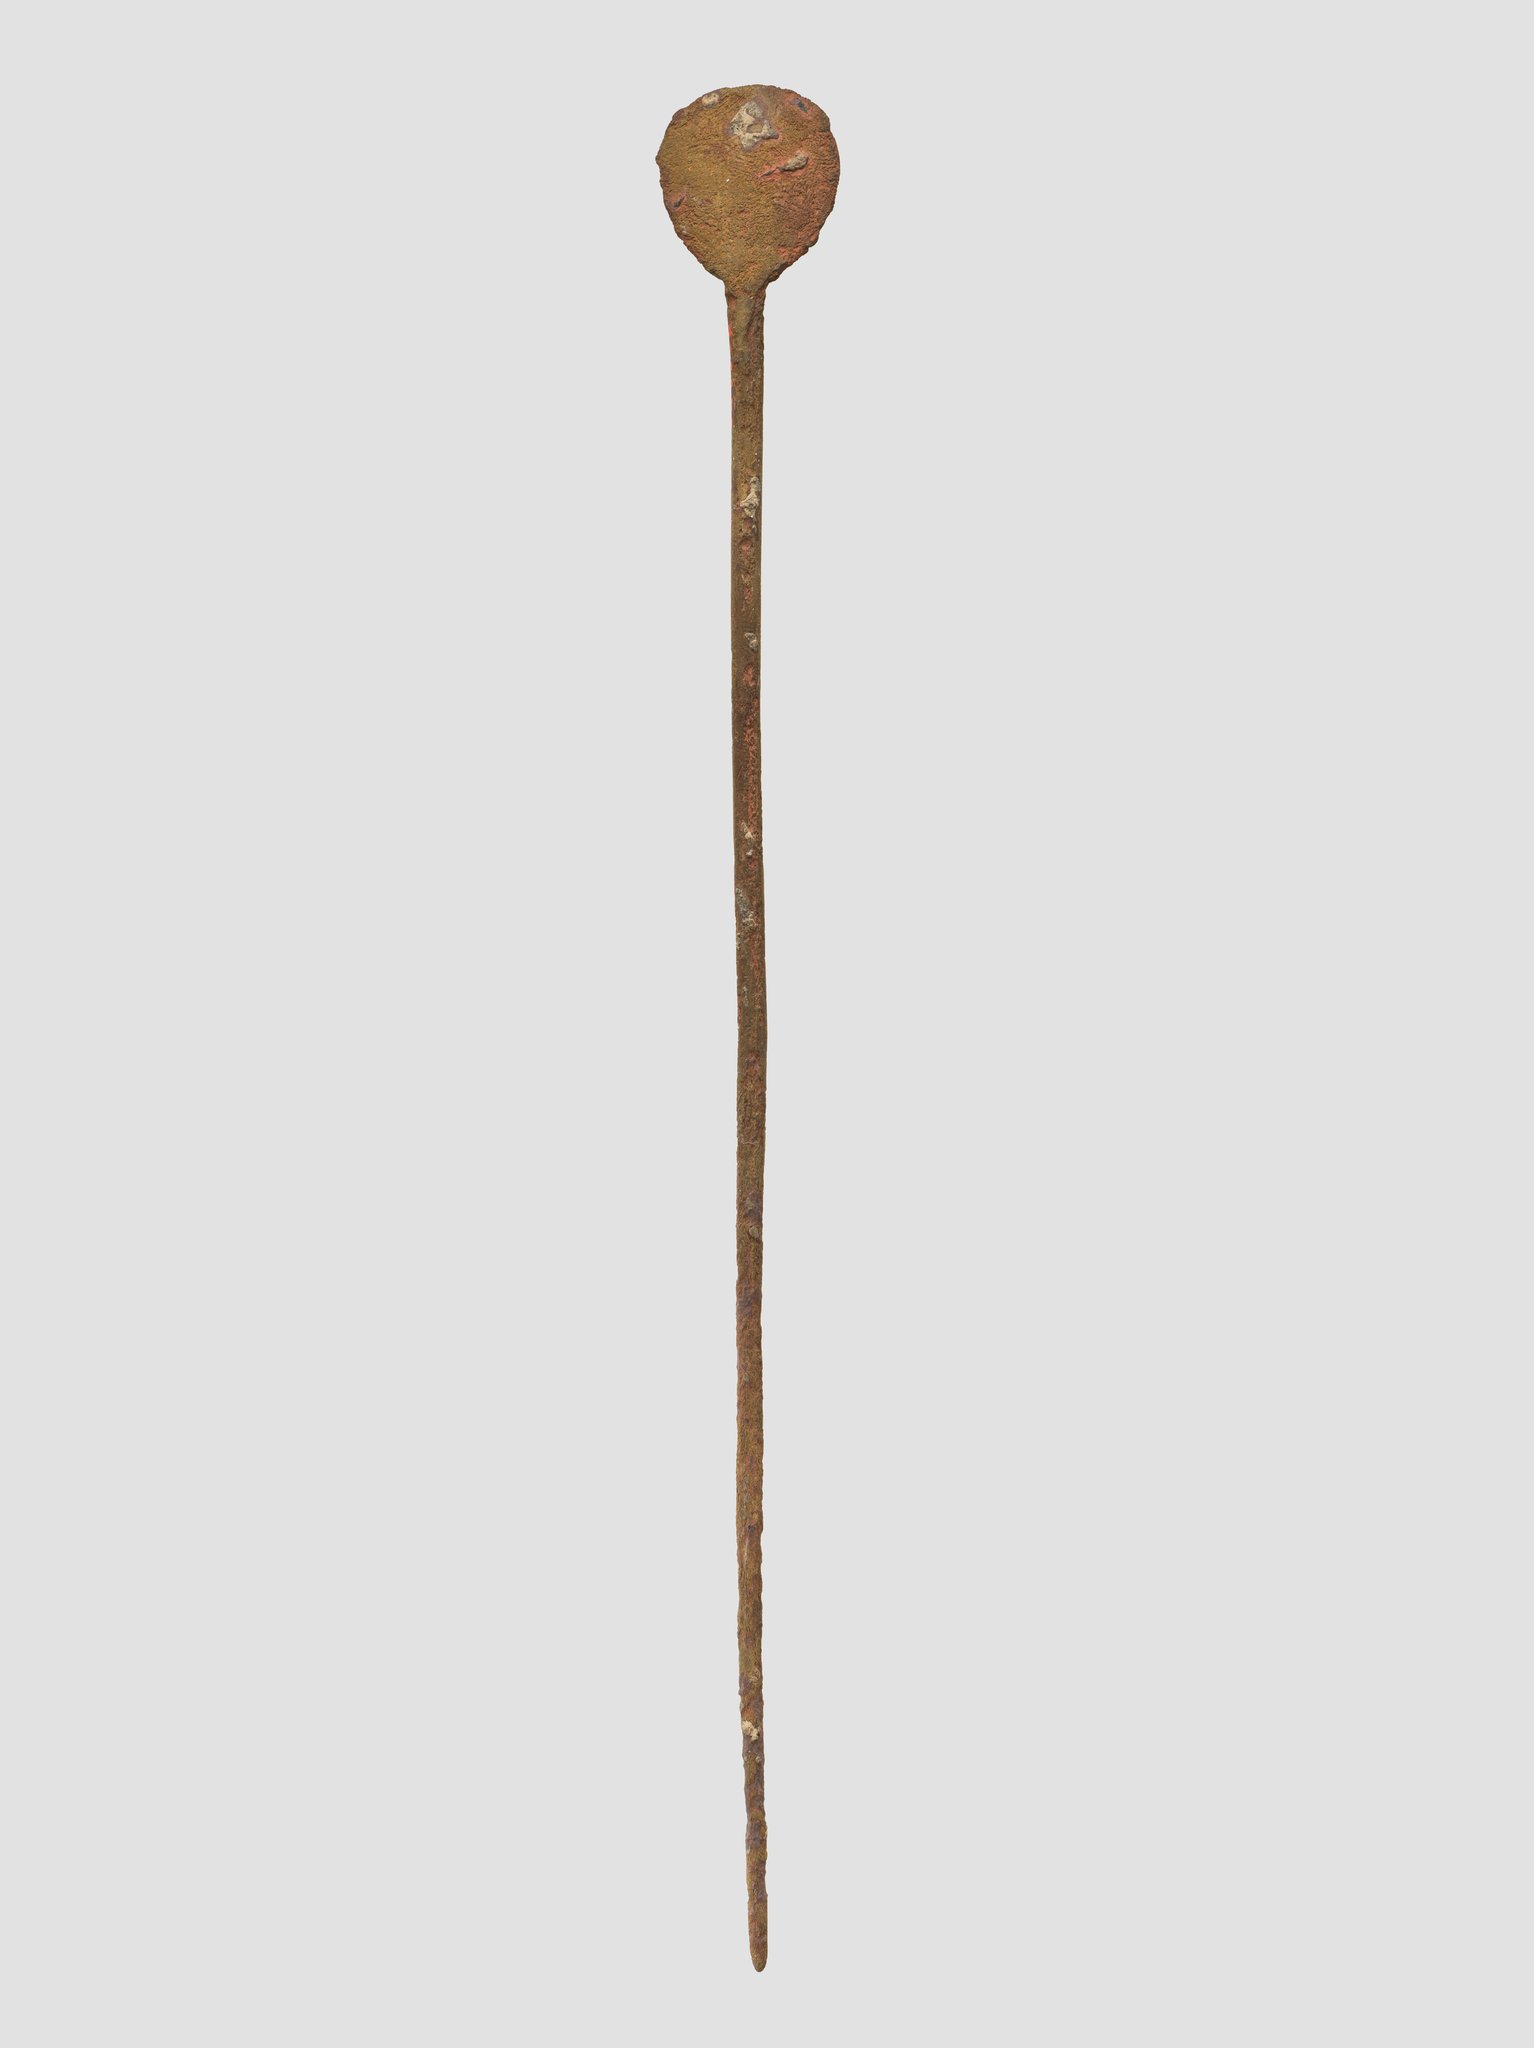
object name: pin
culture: sasanian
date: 201-700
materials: bronze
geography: iran